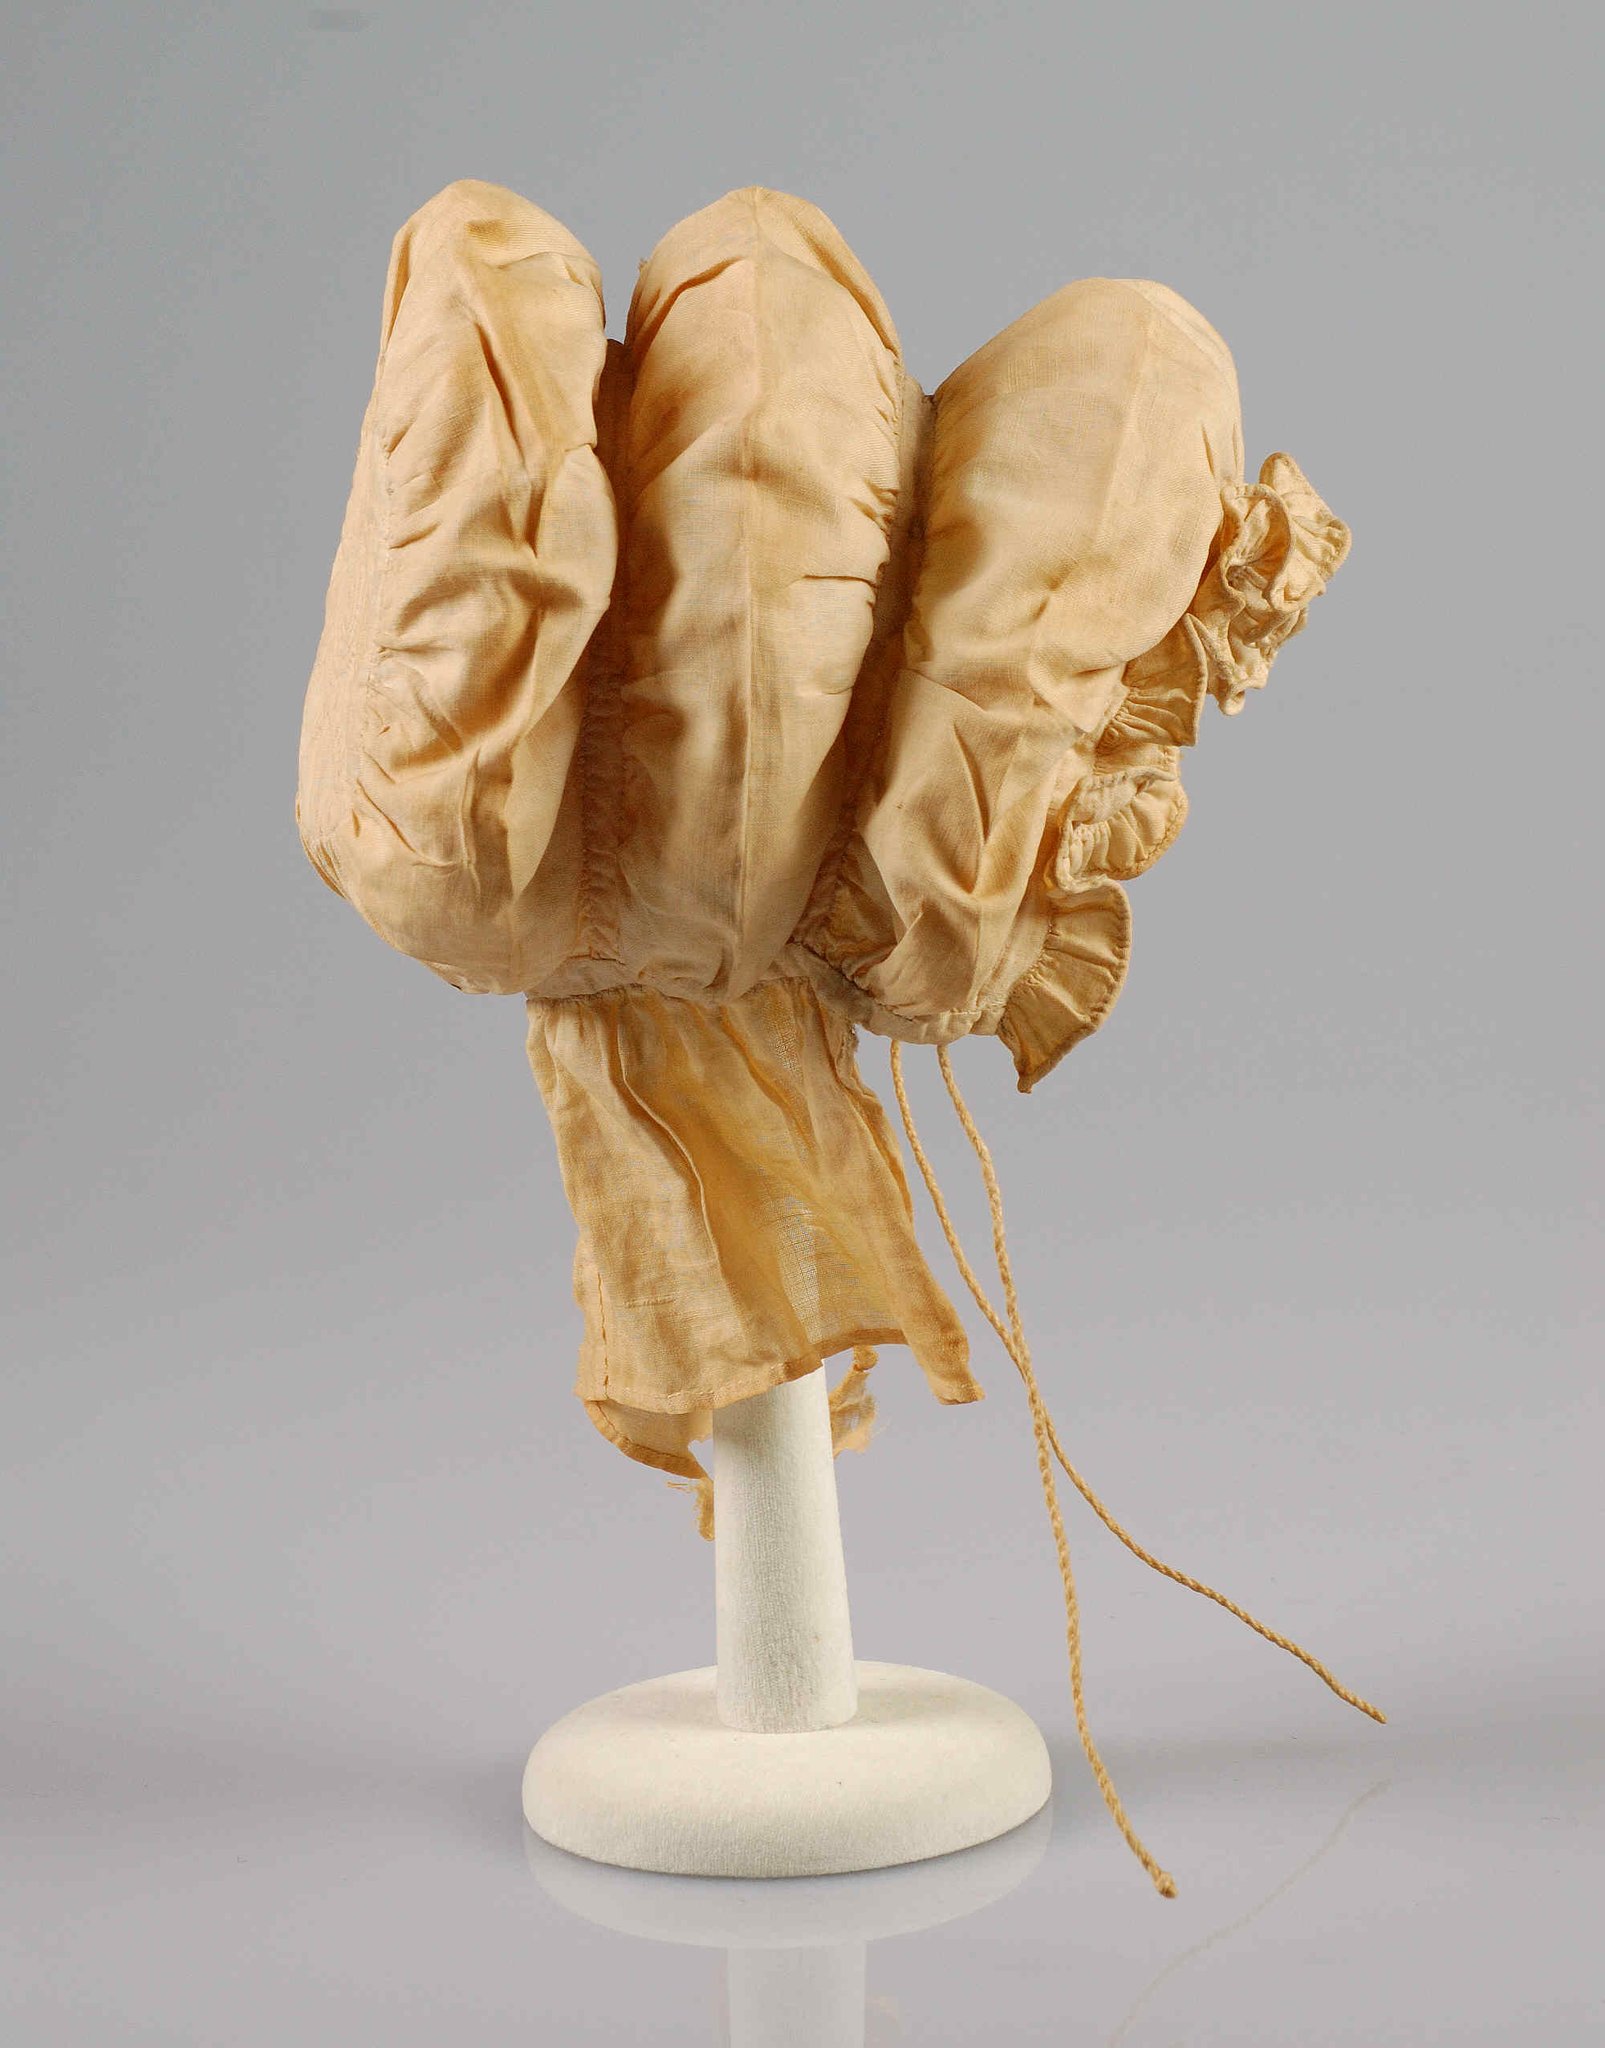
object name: cap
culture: american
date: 1810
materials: cotton